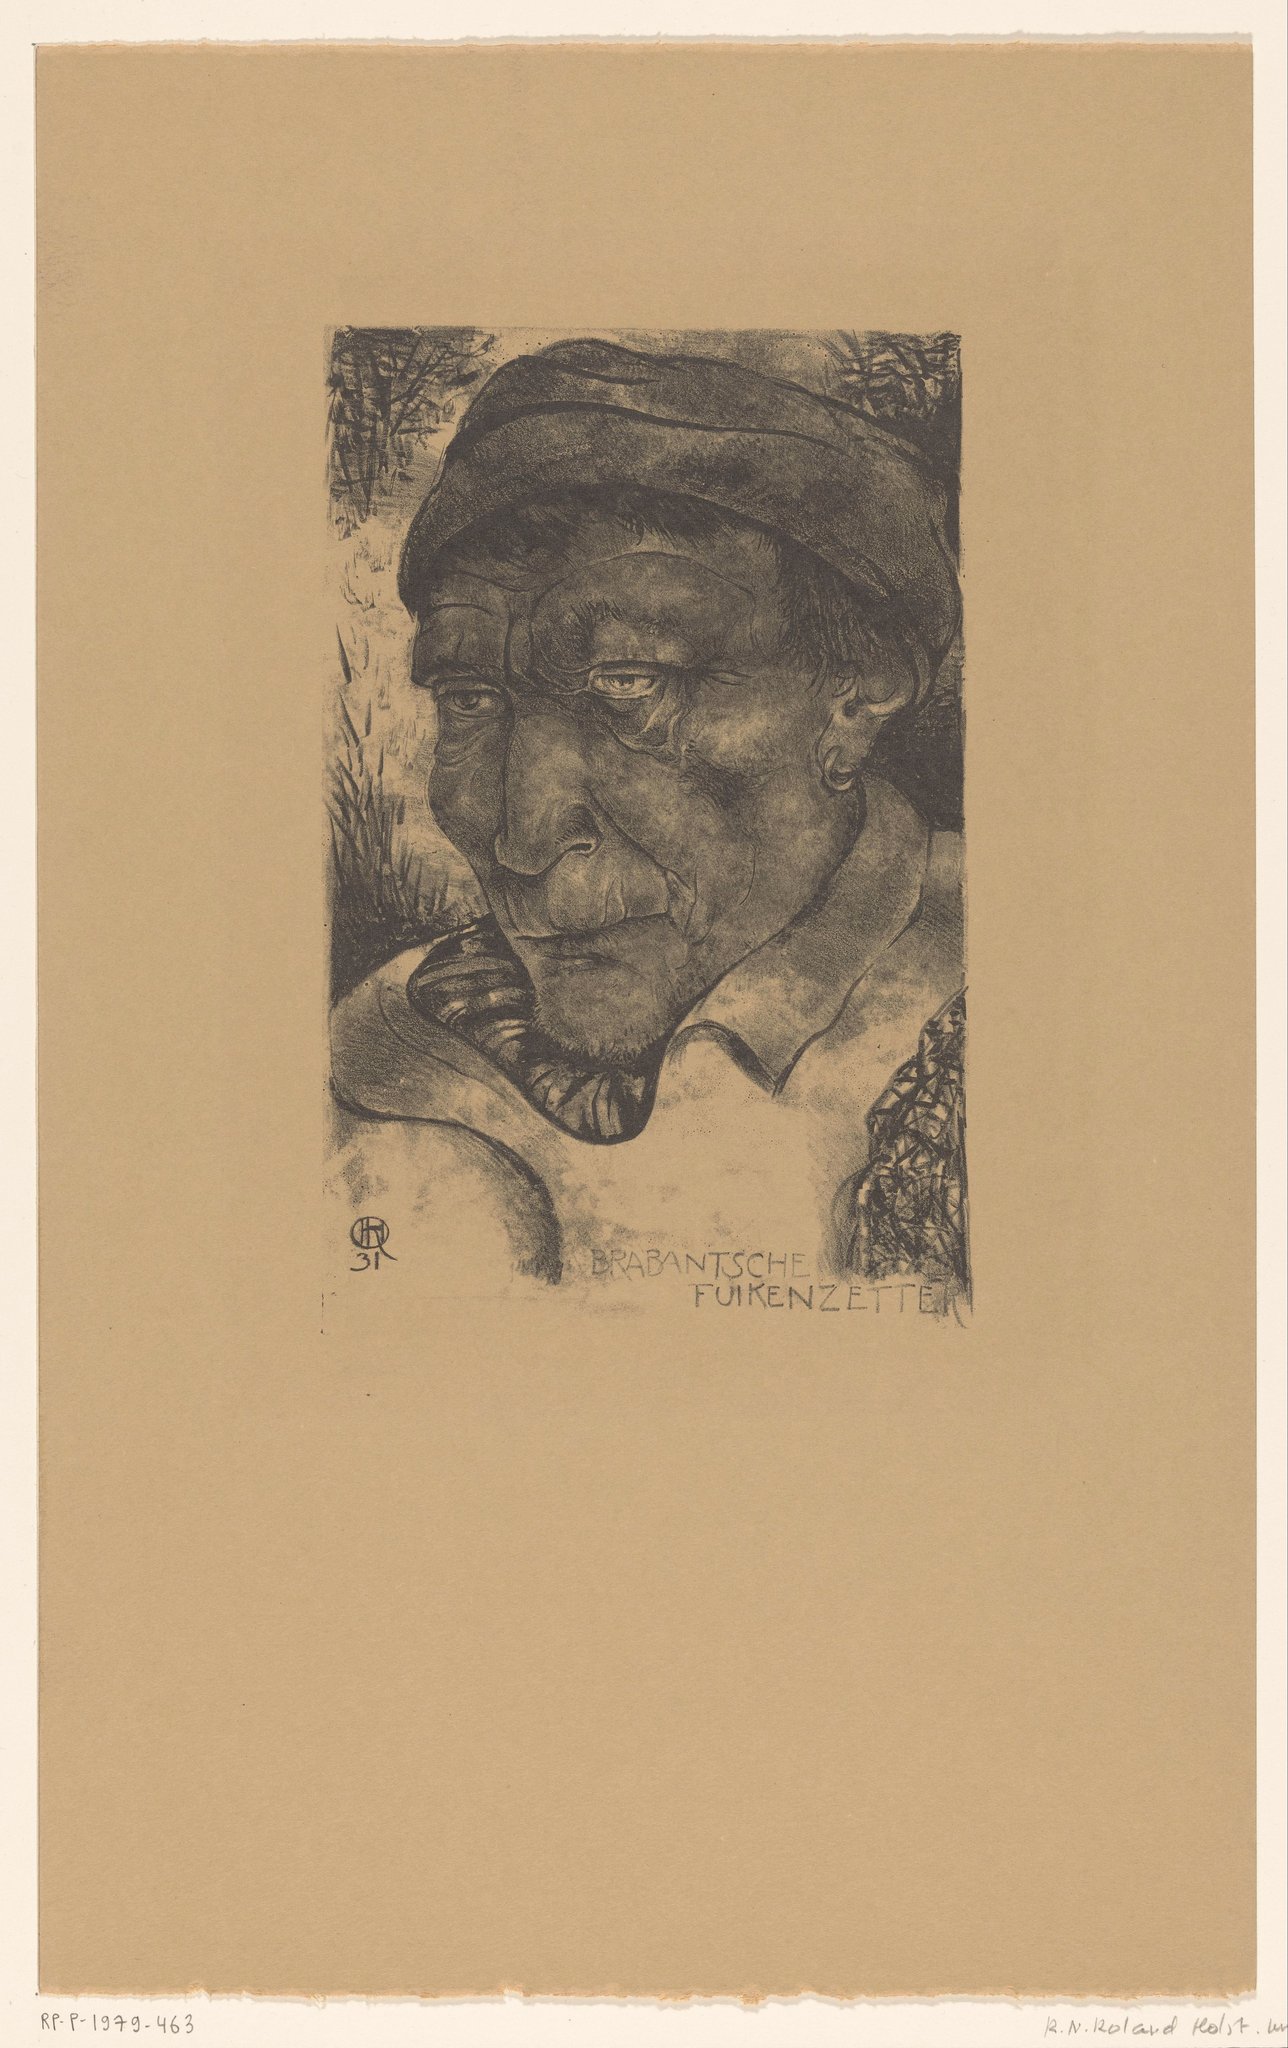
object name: print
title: Brabantse types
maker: richard nicolaüs roland holst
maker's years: 1868-1938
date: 1931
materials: paper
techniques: lithograph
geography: buissche heide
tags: head (human), fisherman, ear-rings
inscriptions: collector's mark: Lugt 2228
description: Een man met een oorring en een hoofddeksel.